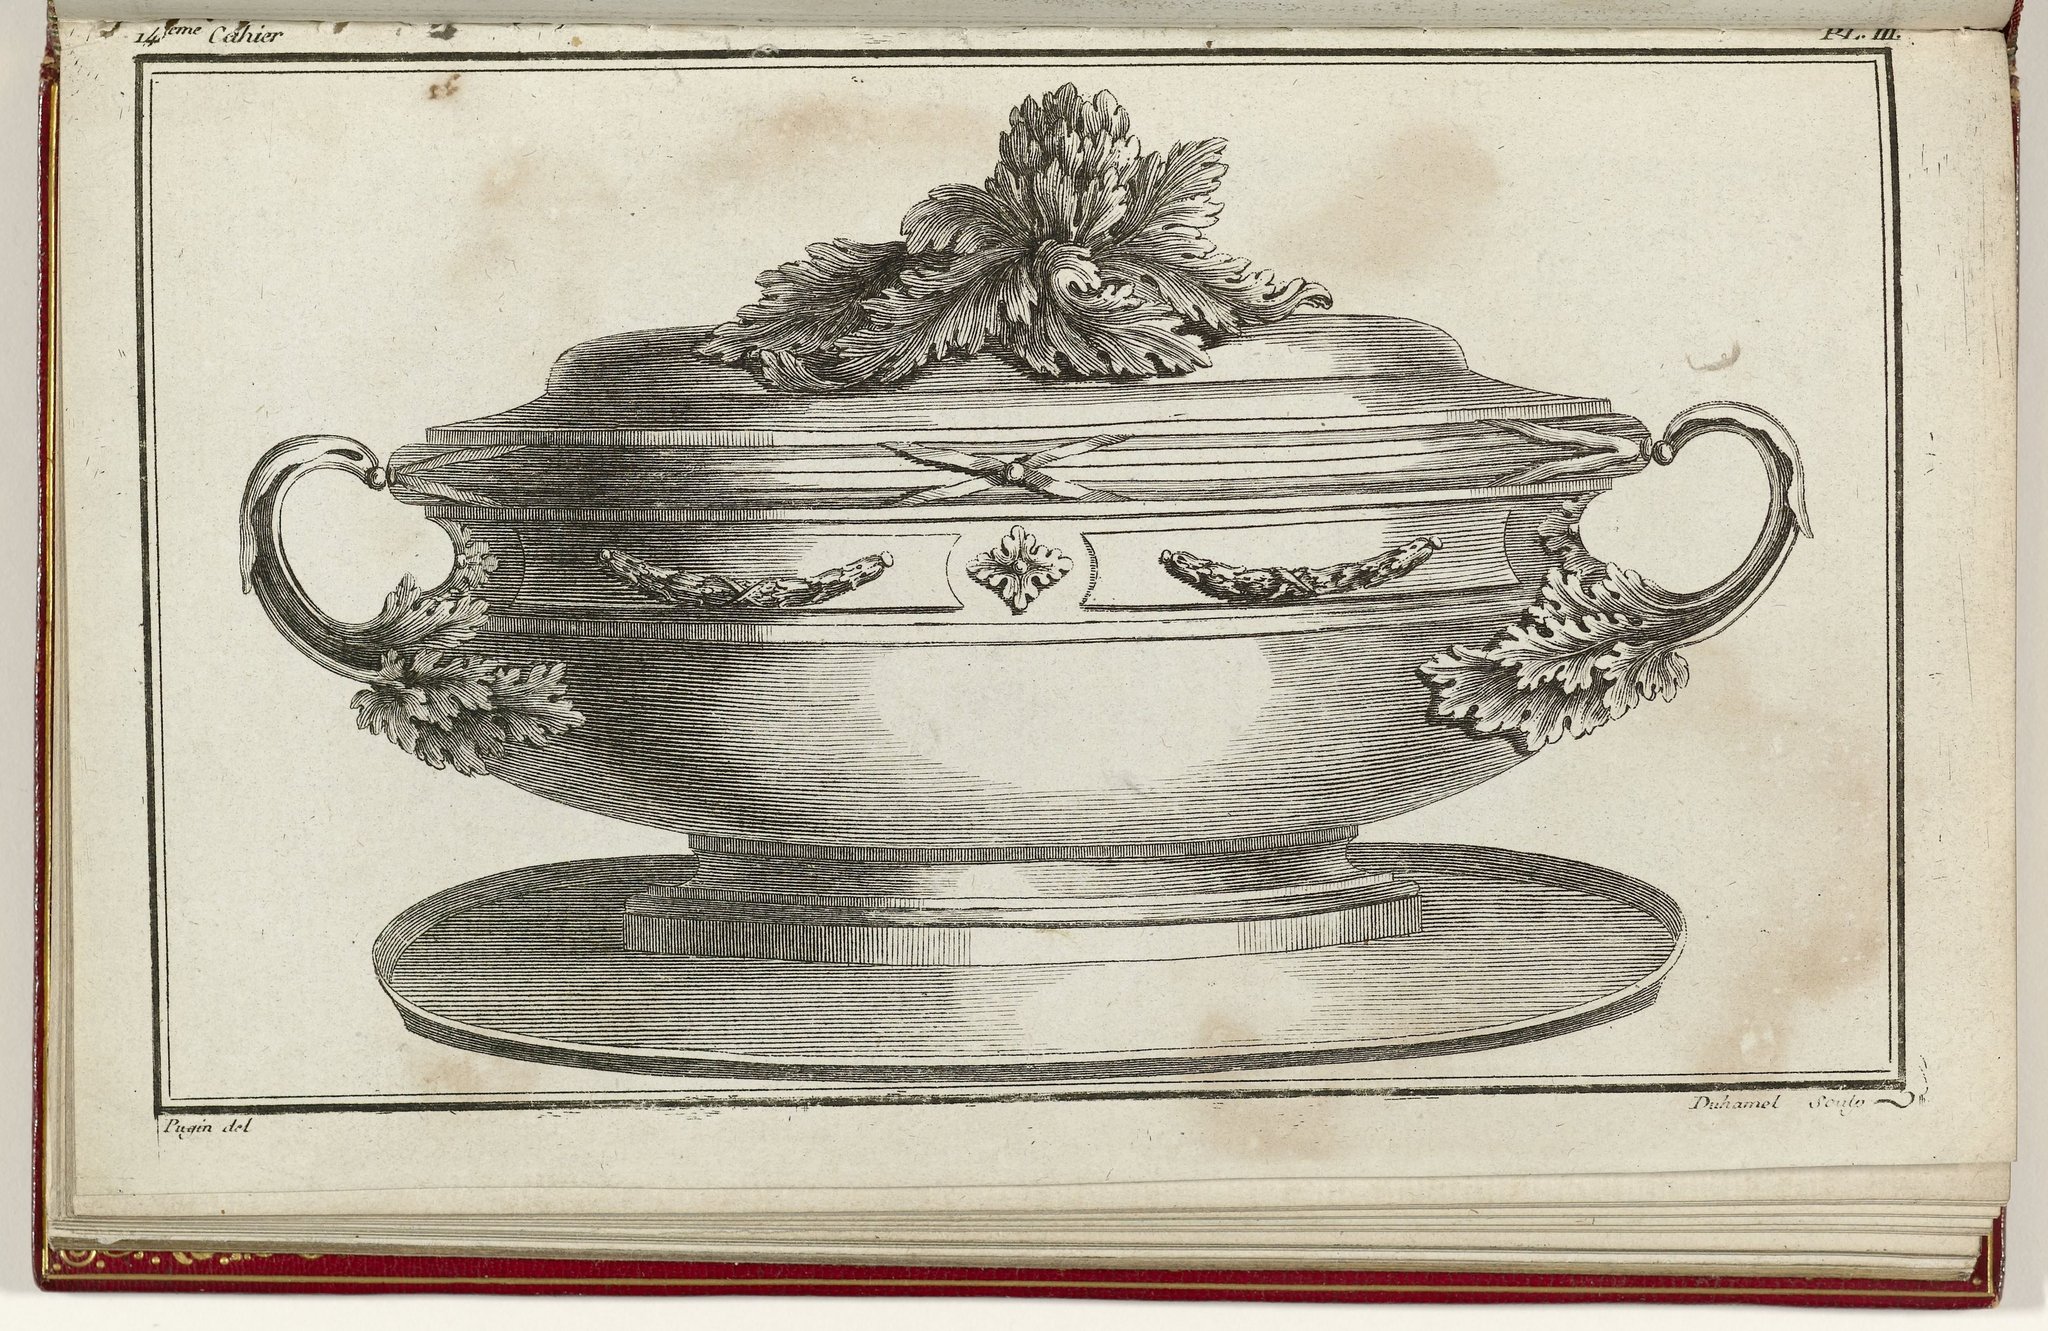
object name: print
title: Cabinet des Modes ou les Modes Nouvelles, 1 Juin 1786, pl. III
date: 1786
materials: paper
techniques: engraving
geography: paris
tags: fashion plates